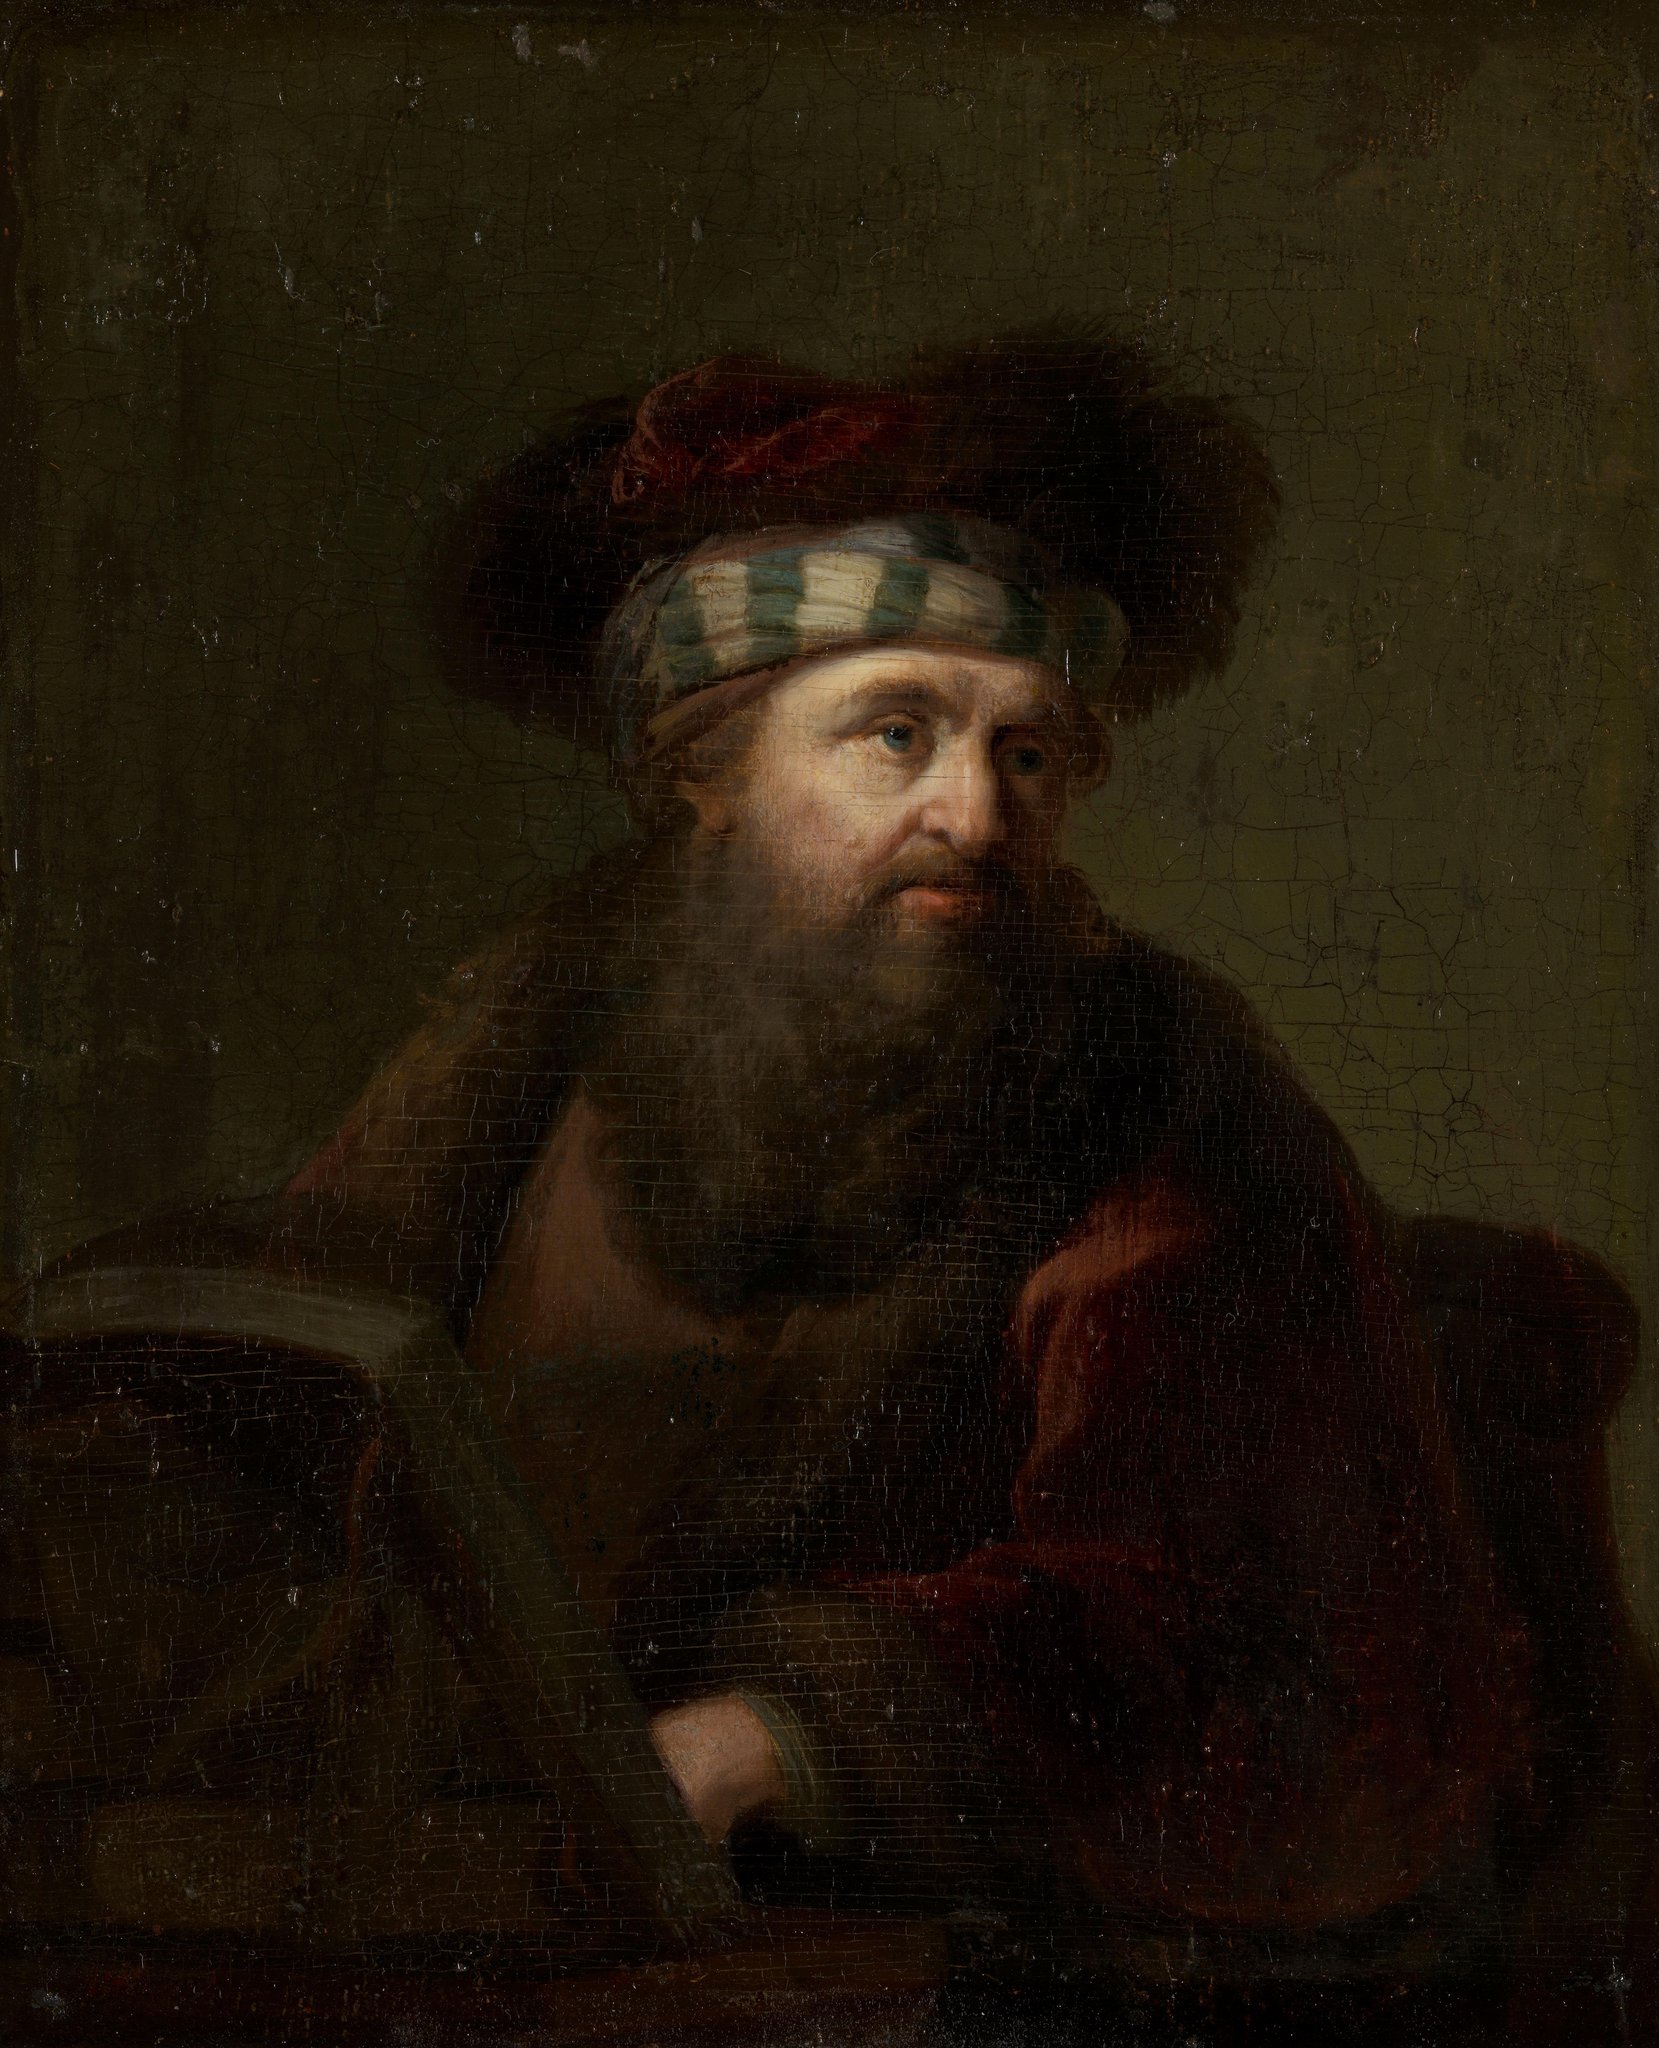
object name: painting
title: A Man in Oriental Costume (Portrait of a Rabbi)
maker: ary de vois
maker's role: painter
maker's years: 1632-1680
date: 1716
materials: oil, panel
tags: rabbi, historical persons not known by name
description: Portret van een rabbijn zittend achter een tafel waarop een opengeslagen boek op een standaard staat. Kopie naar het origineel van Rembrandt in de Glasgow Art Gallery.